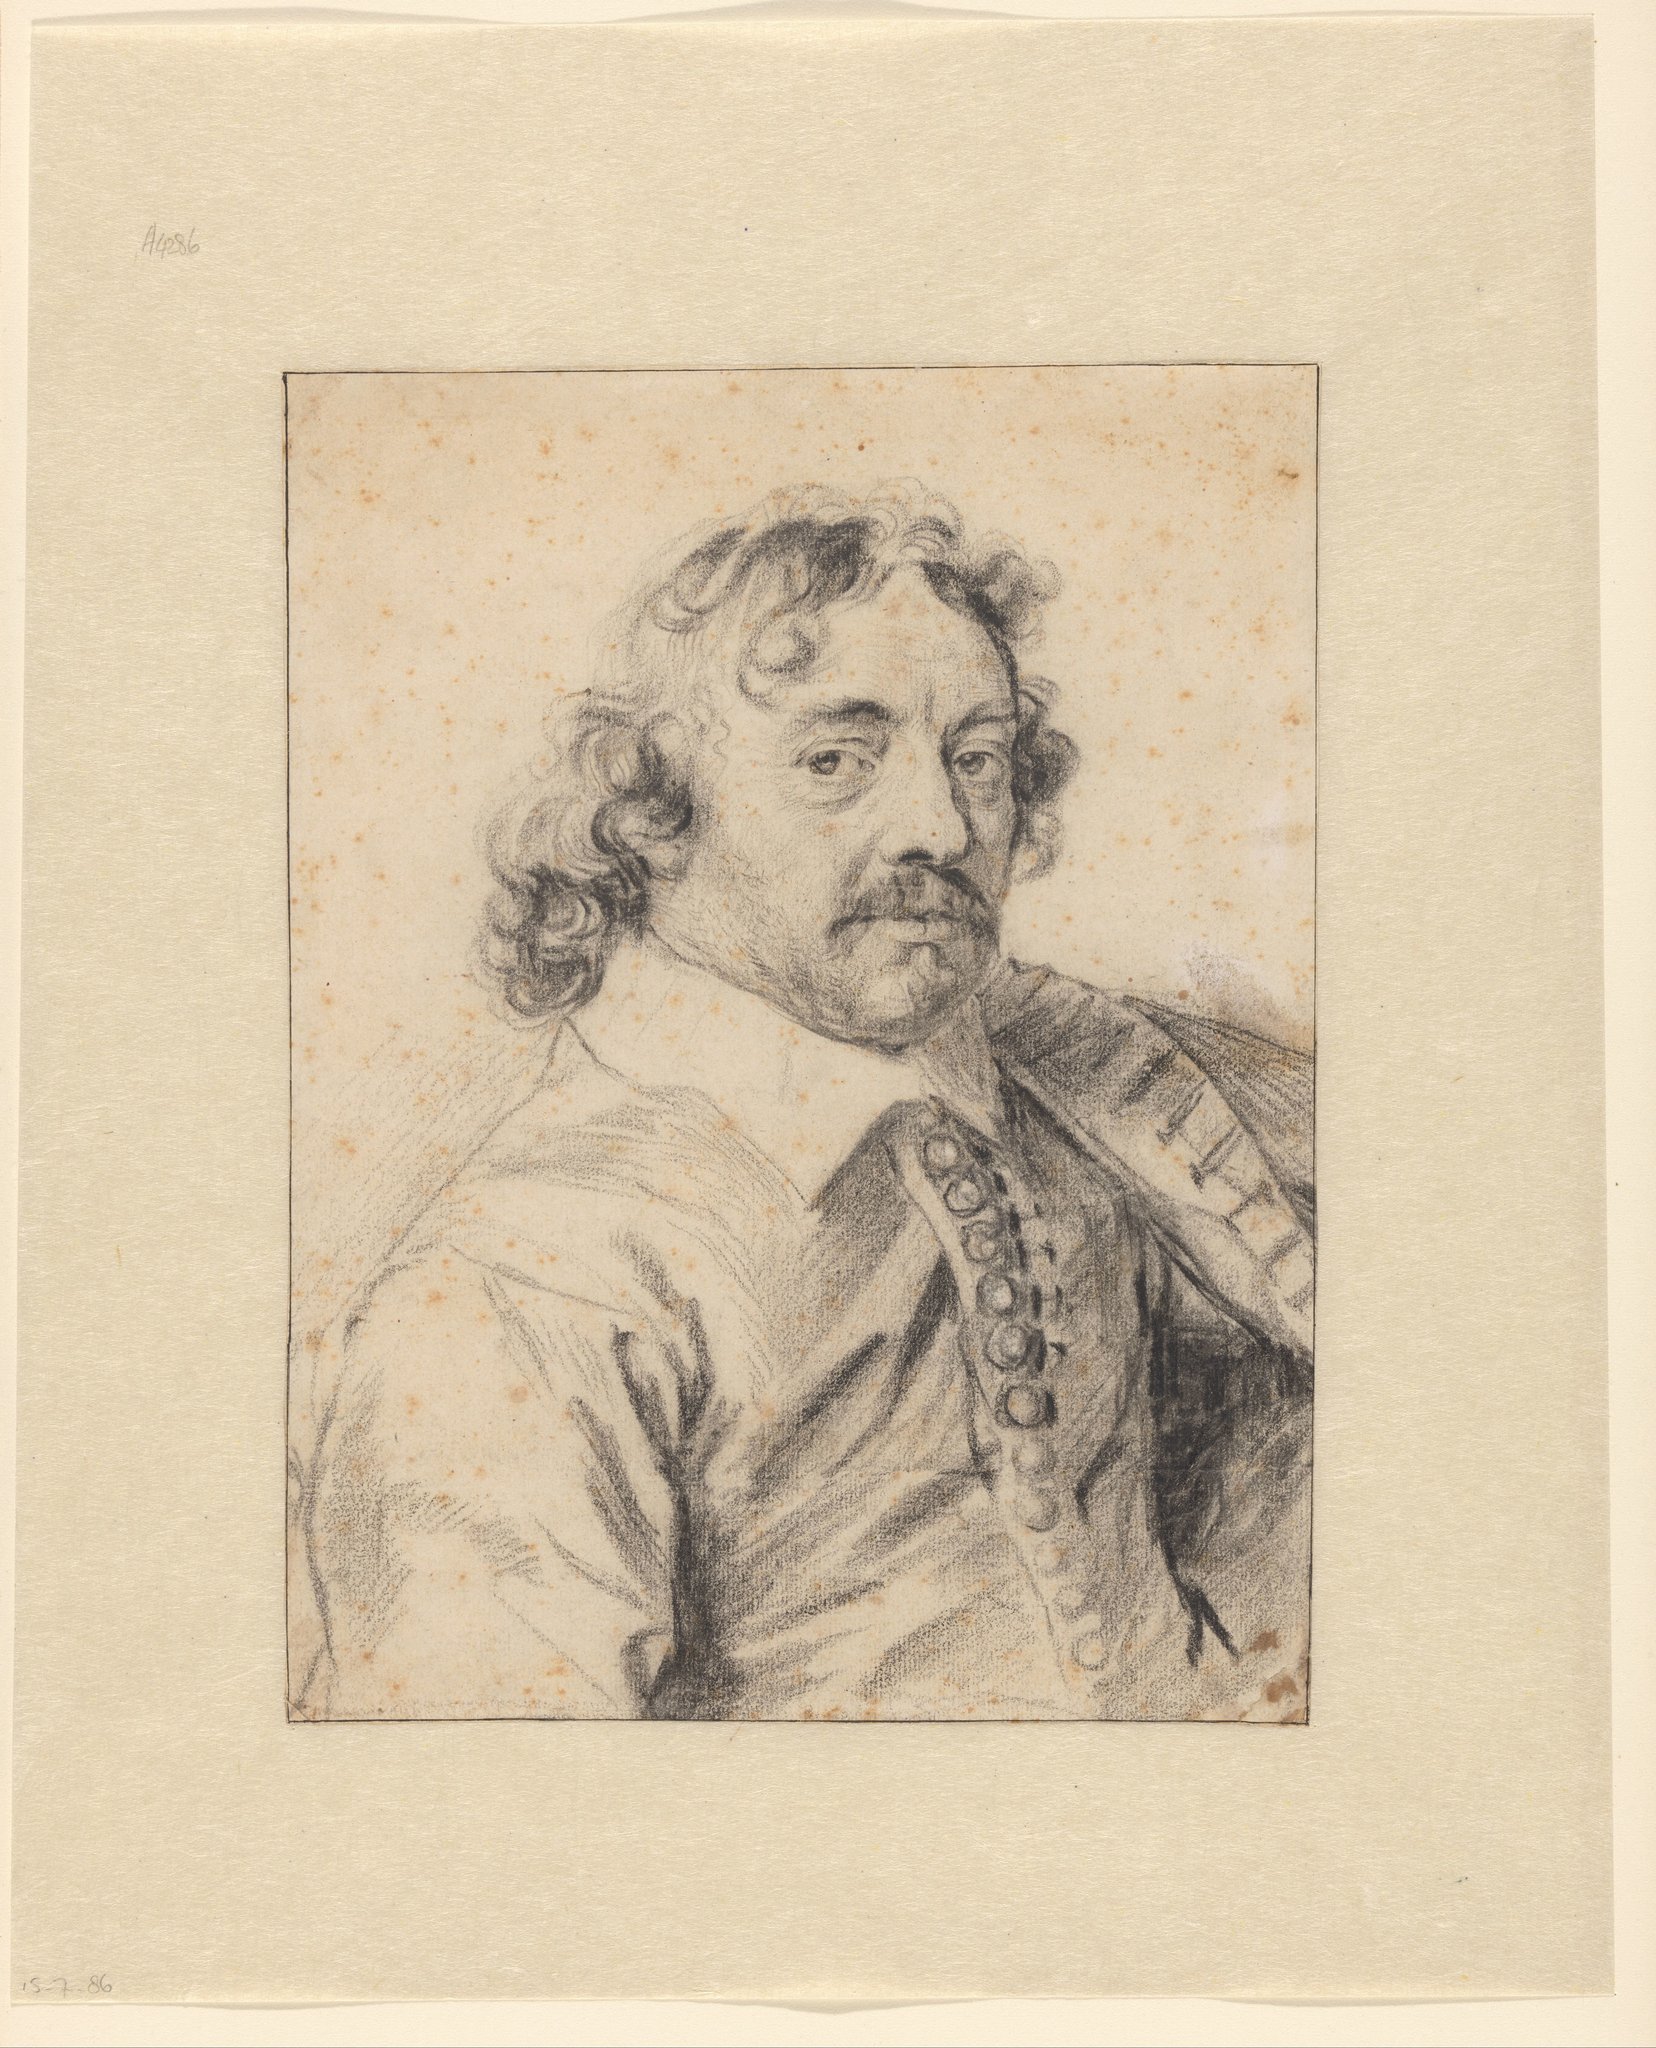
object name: drawing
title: Portret van een onbekende man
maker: jan lievens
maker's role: draughtsman, painter, print maker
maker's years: 1607-1674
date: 1650-1655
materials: chalk, paper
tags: anonymous historical person portrayed alone